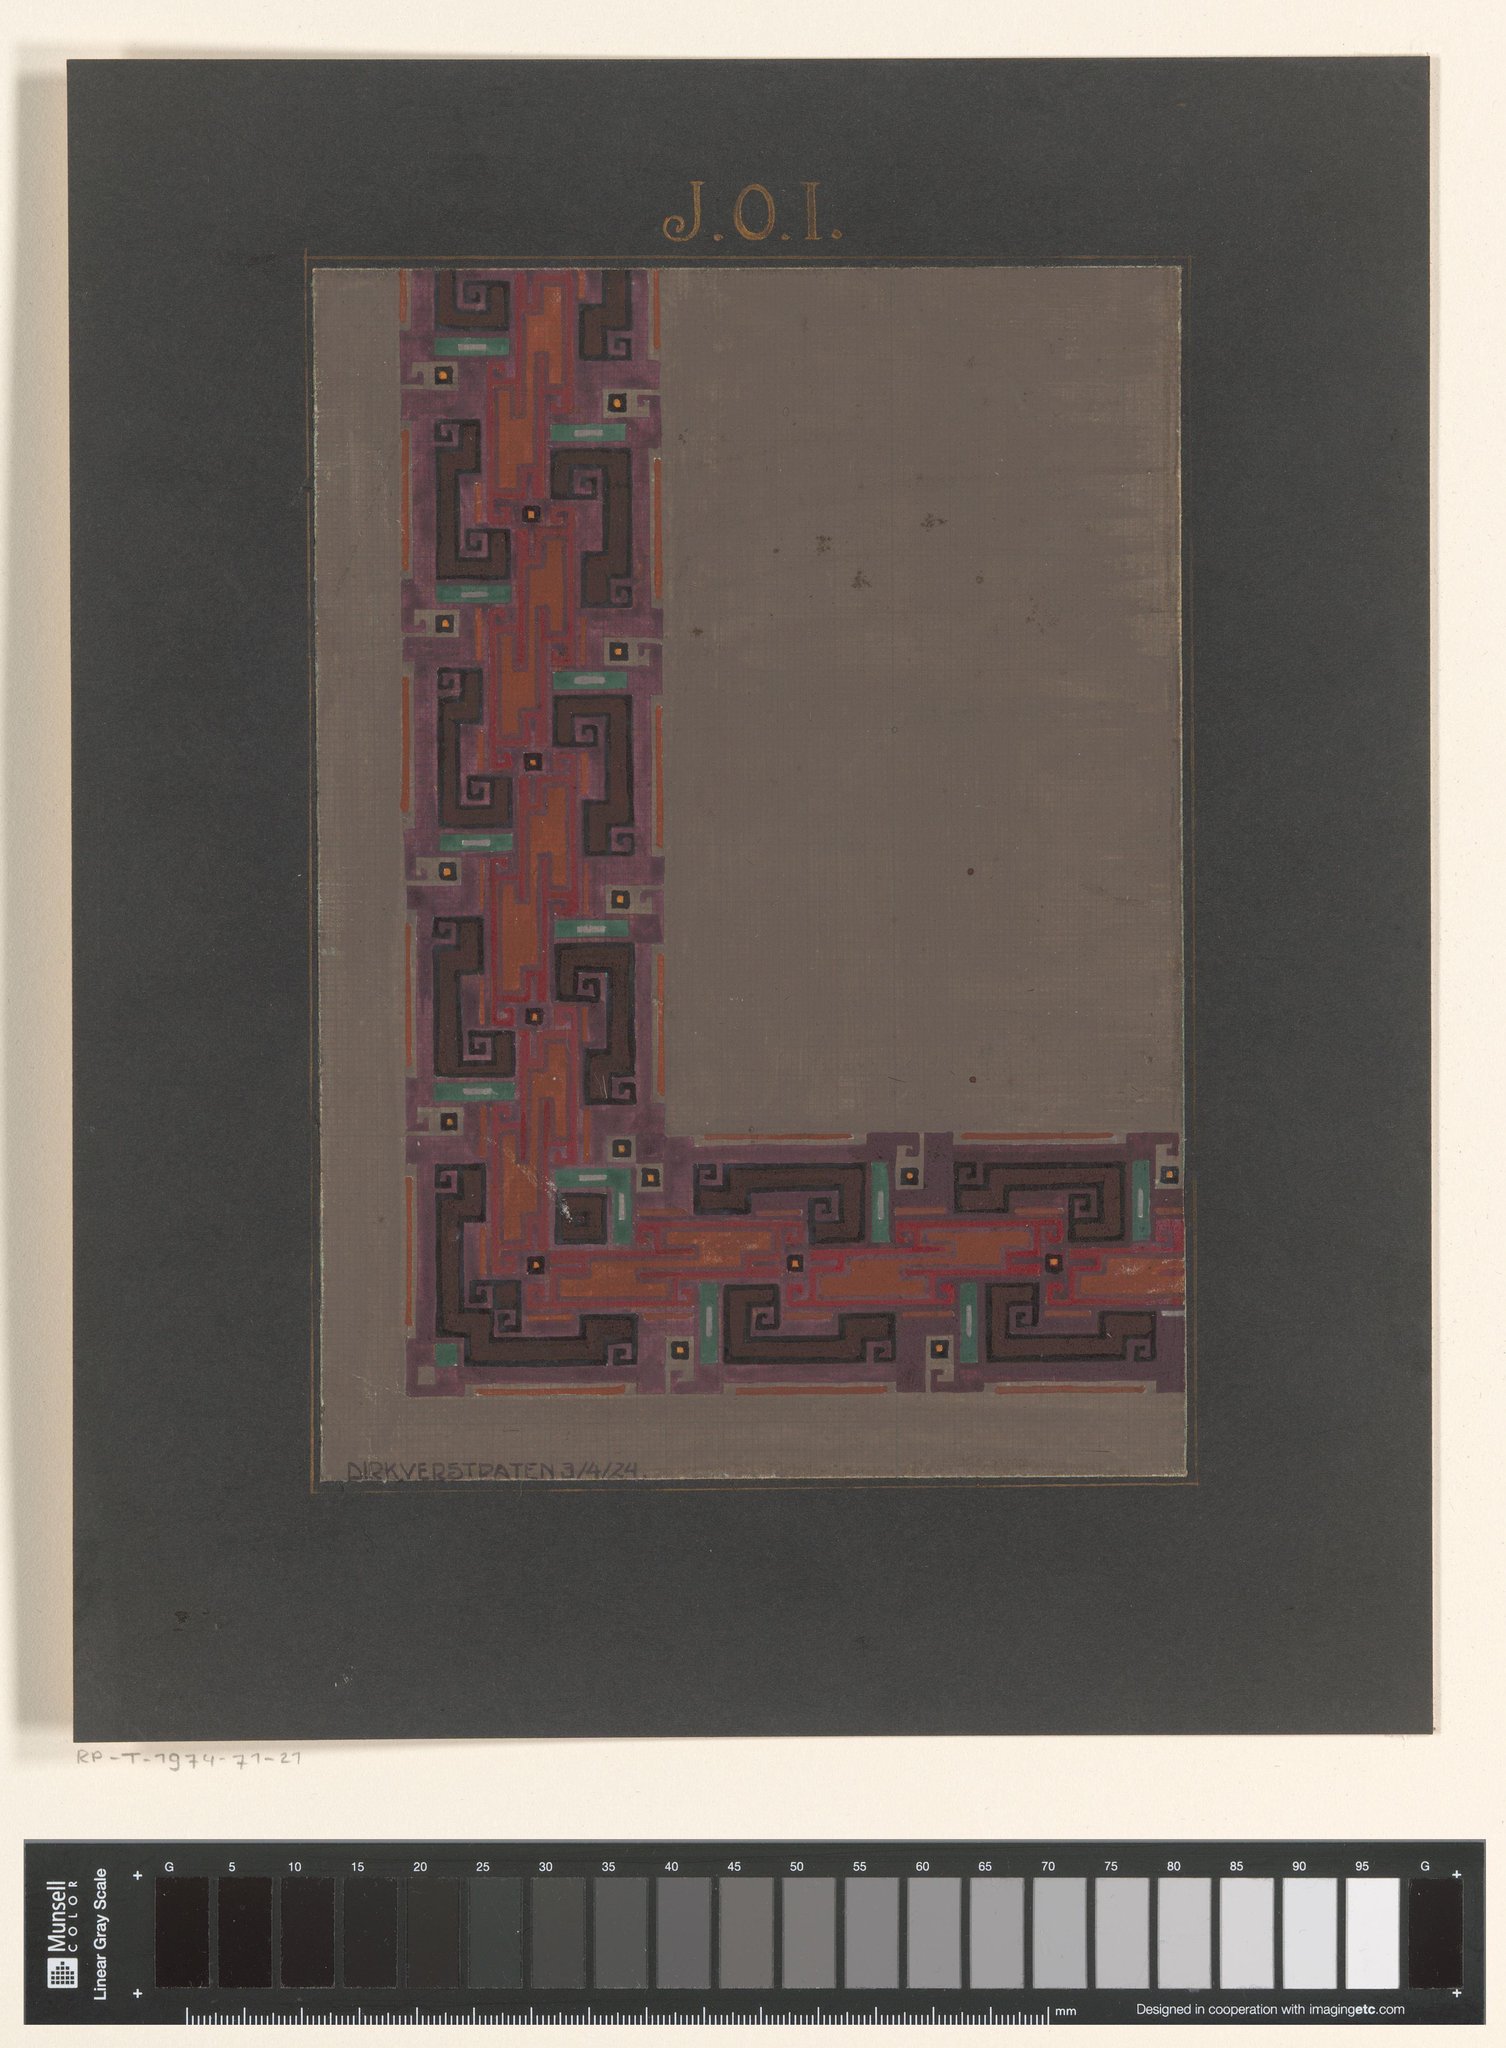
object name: drawing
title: Ontwerp voor een tapijt met geometrisch patroon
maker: dirk verstraten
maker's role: designer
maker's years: 1892-1946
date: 1924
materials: cardboard, paint, paper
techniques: brush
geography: amsterdam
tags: ornament ~ geometric motifs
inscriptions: number: ‘12’, inscription: ‘J.O.I.’, collector's mark: ‘R:MVS’